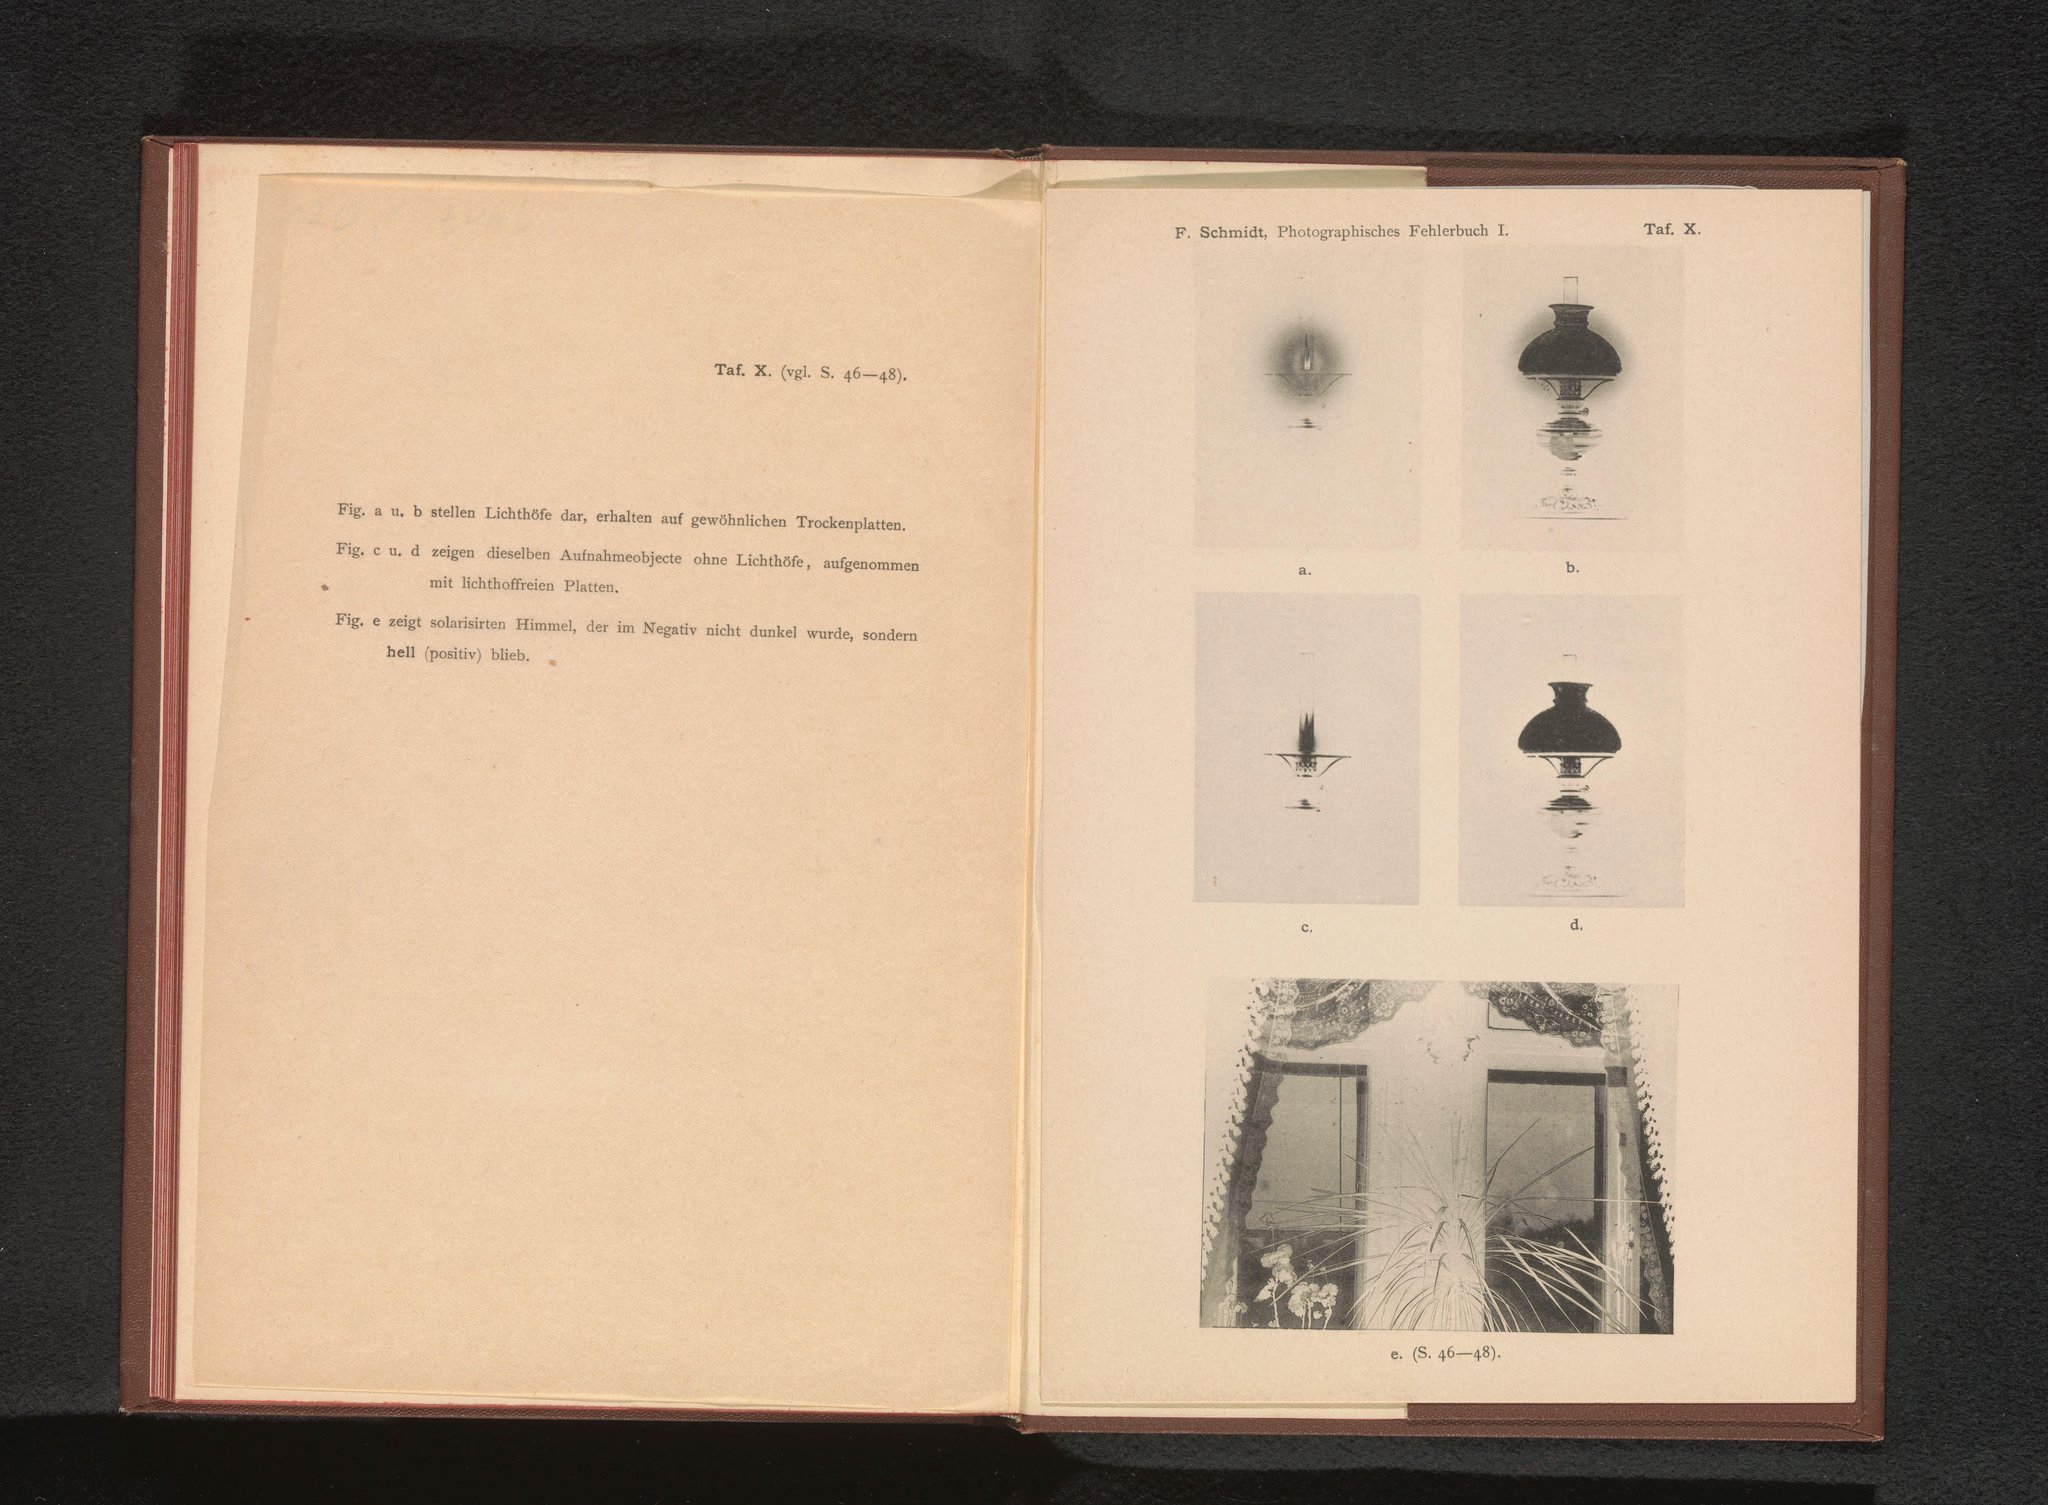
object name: page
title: Vier voorbeelden van opnames van een lamp op twee verschillende soorten platen en een voorbeeld van een correcte opname van de hemel in een raam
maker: Anonymous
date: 1890-1895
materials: paper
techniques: photograph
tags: window, oil-lamp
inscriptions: number: ‘Taf. X.’, inscription: ‘a. b./ c. d./ e. (S. 46-48).’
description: Prenten op losse bladen. Bladen in insteekhoes achterin boek.